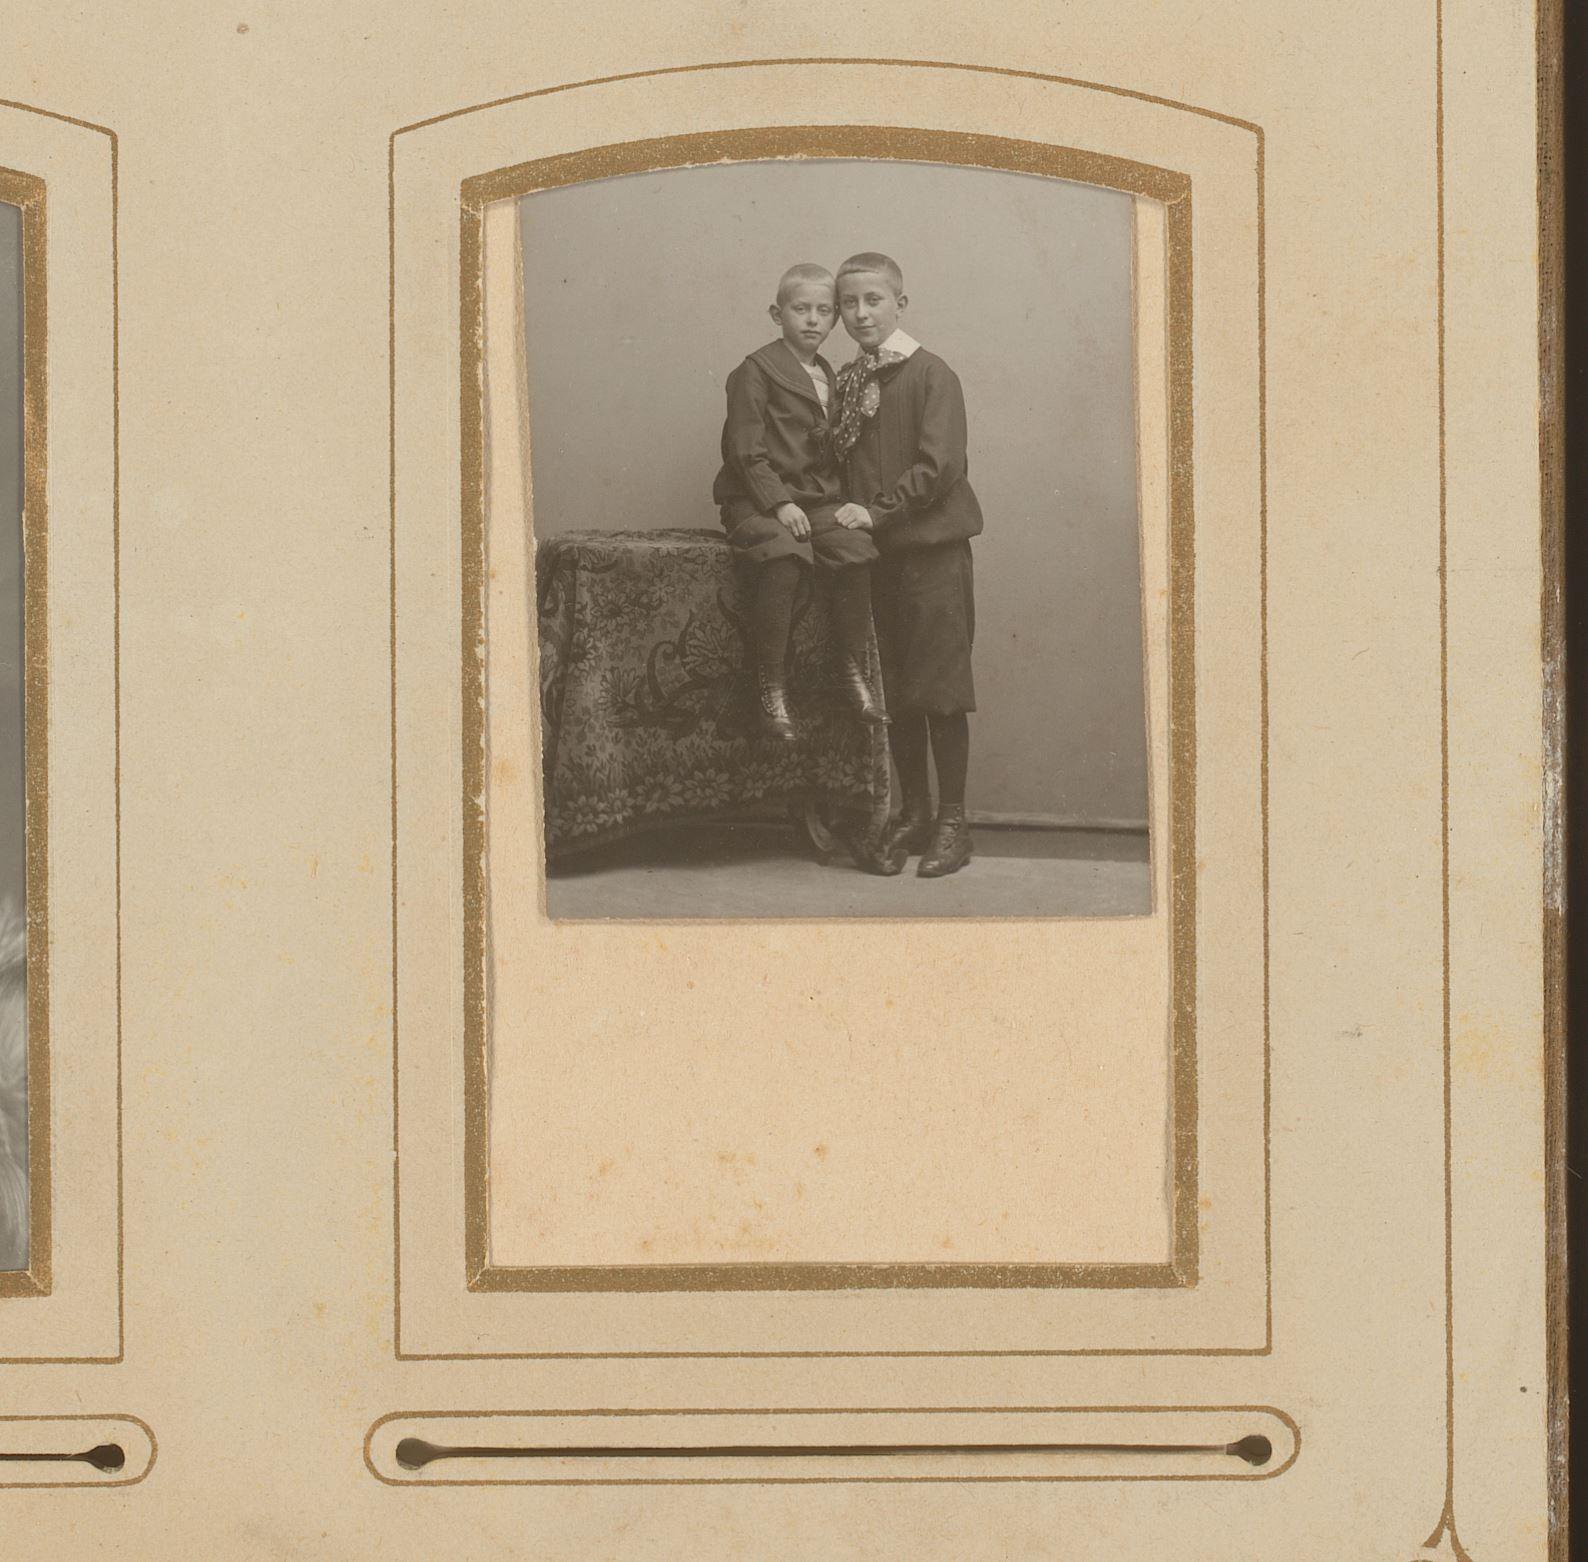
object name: album leaf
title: Portret van broer en zus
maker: Anonymous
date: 1880-1910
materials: cardboard, photographic support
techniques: collodion silver print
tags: boy (child between toddler and youth), girl (child between toddler and youth), brothers or sisters (second degree family relationships)